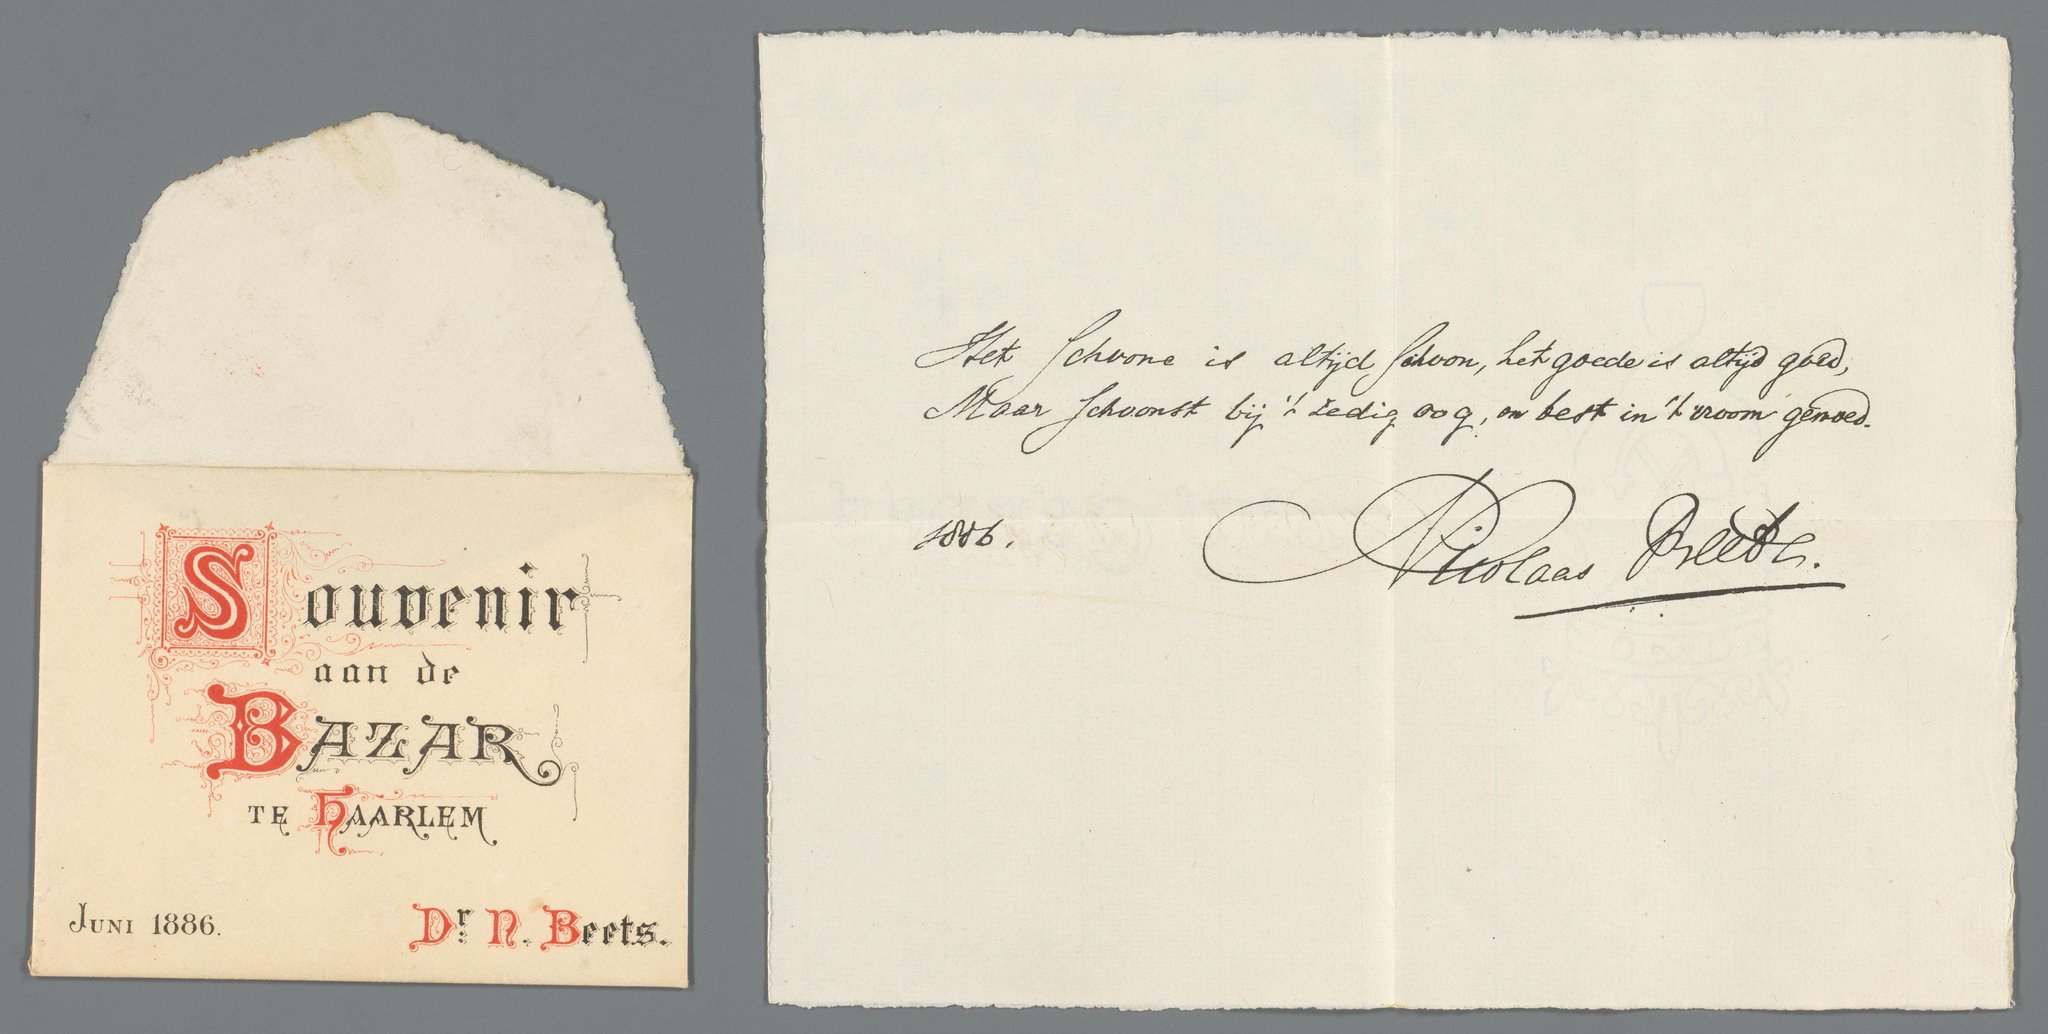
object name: text sheet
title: Souvenir aan de Bazaar te Haarlem / Juni 1886 / Dr. N. Beets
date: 1806-1886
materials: paper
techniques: lithograph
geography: haarlem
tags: haarlem, utrecht, nicolaas beets, advertising, souvenir (~ tourism)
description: Envelop met opdruk 'Souvenir aan de Bazaar te Haarlem' met daarin een opgevouwen blad met twee regels tekst, een aforisme, door Nicolaas Beets en het jaartal 1886.